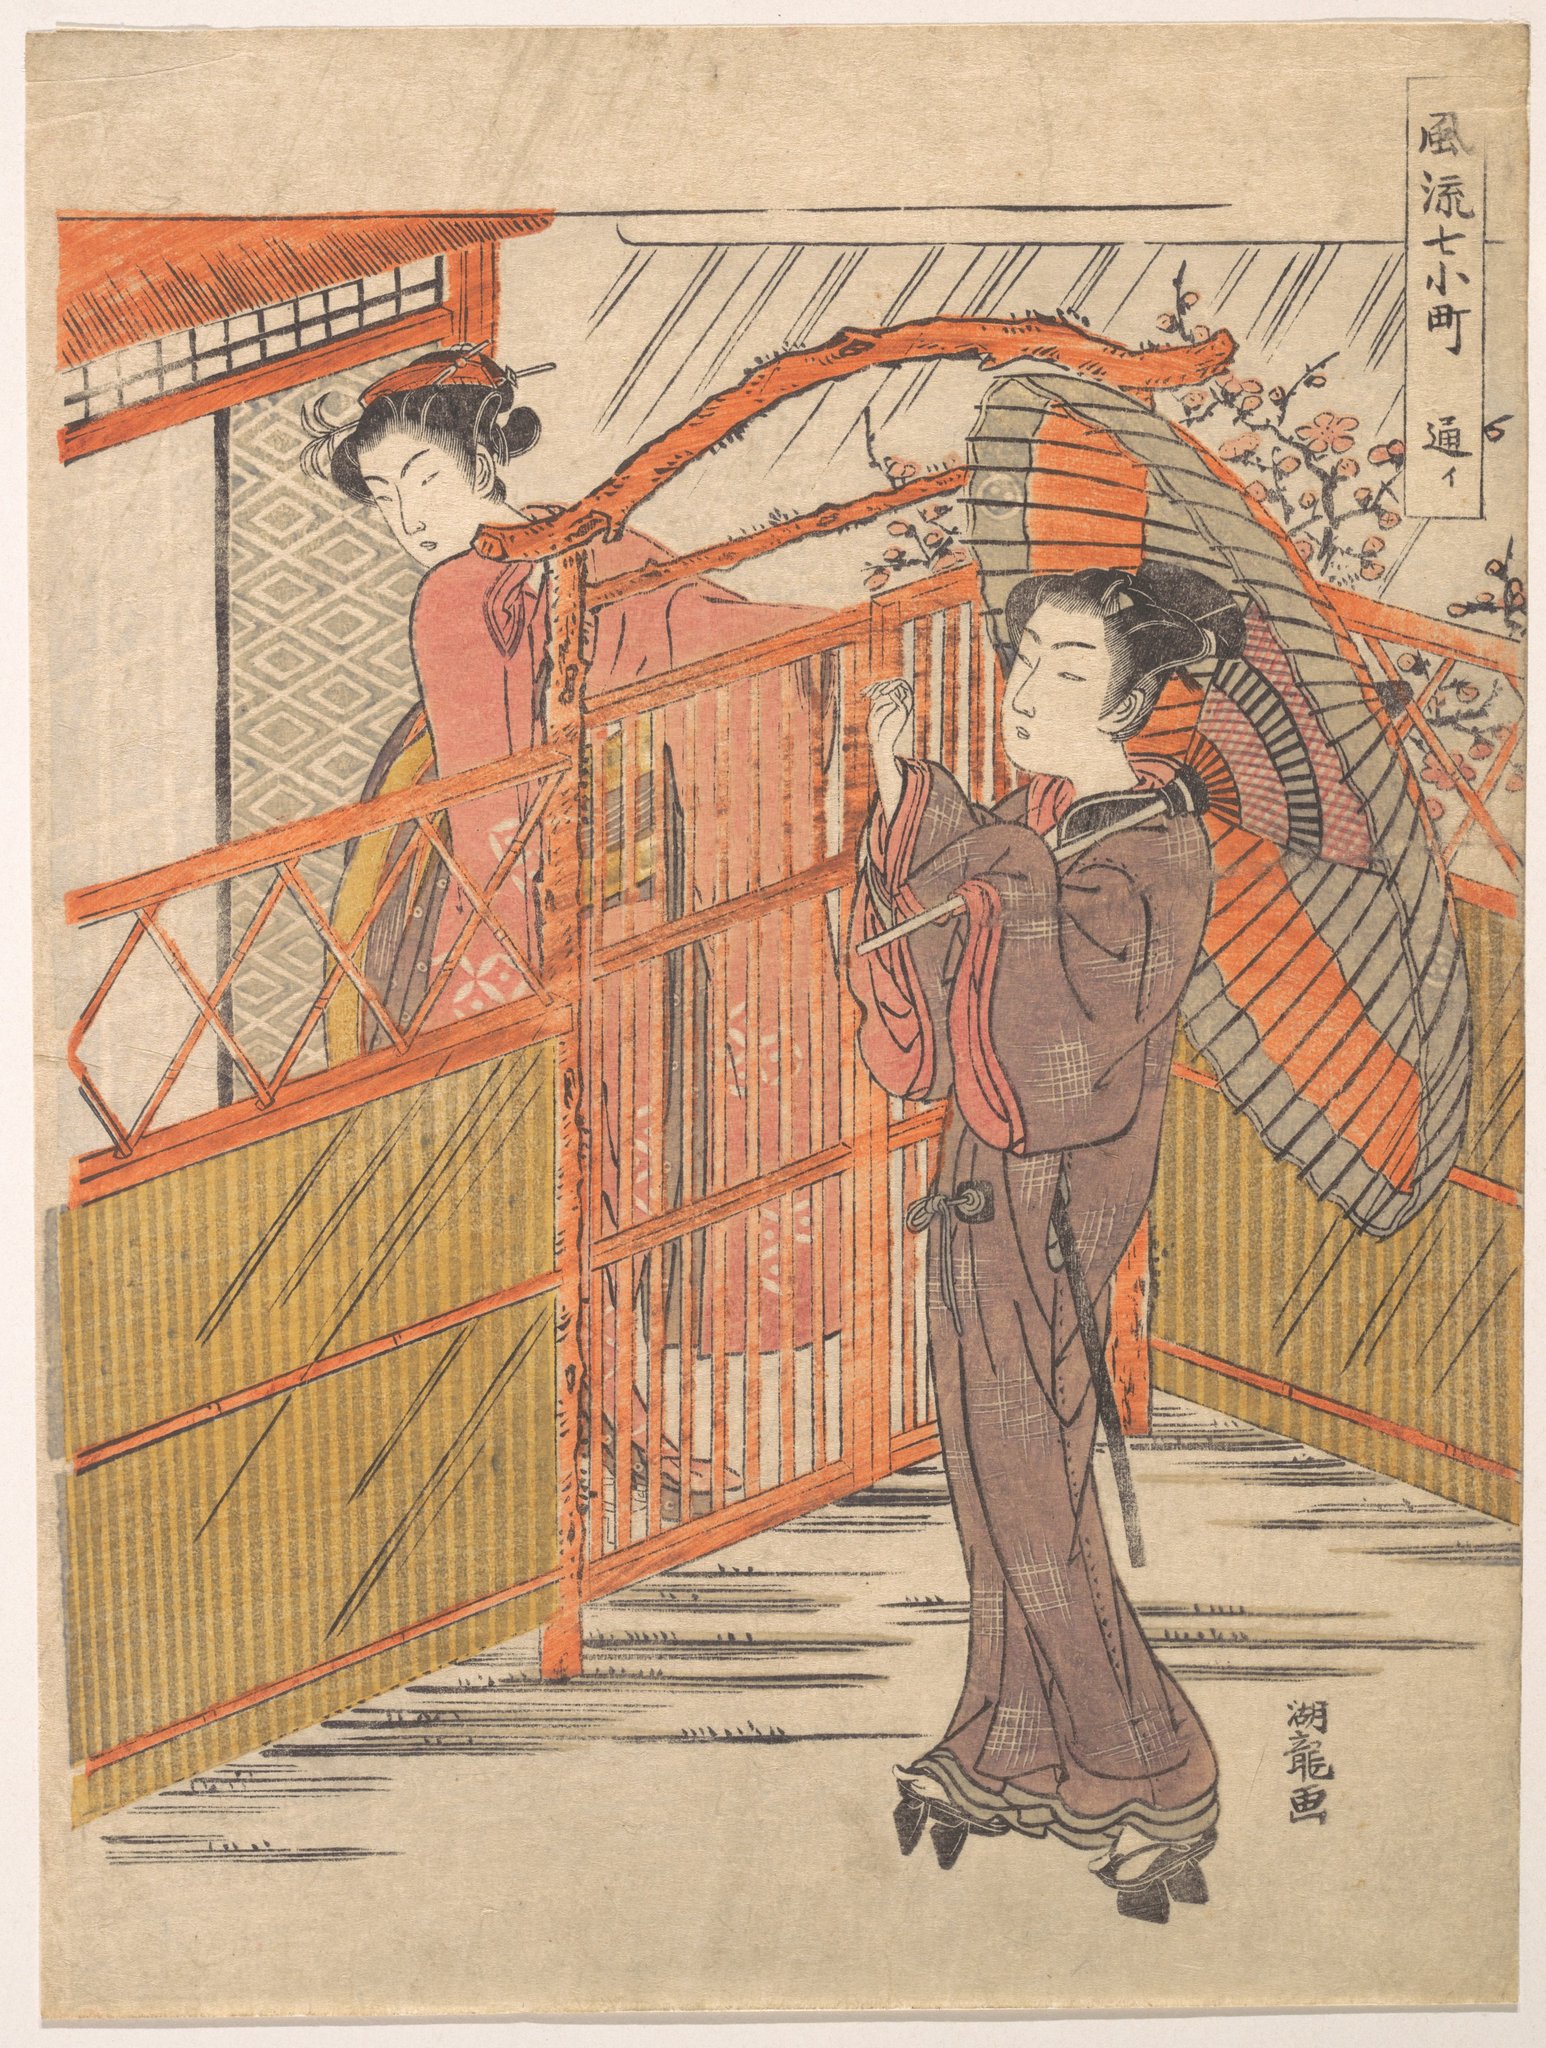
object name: print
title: "Visiting," from the Series Seven Fashionable Komachi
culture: japanese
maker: isoda koryūsai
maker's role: artist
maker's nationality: japanese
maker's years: 1735-1790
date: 1770-1790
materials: ink, paper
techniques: woodblock print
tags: gates,women